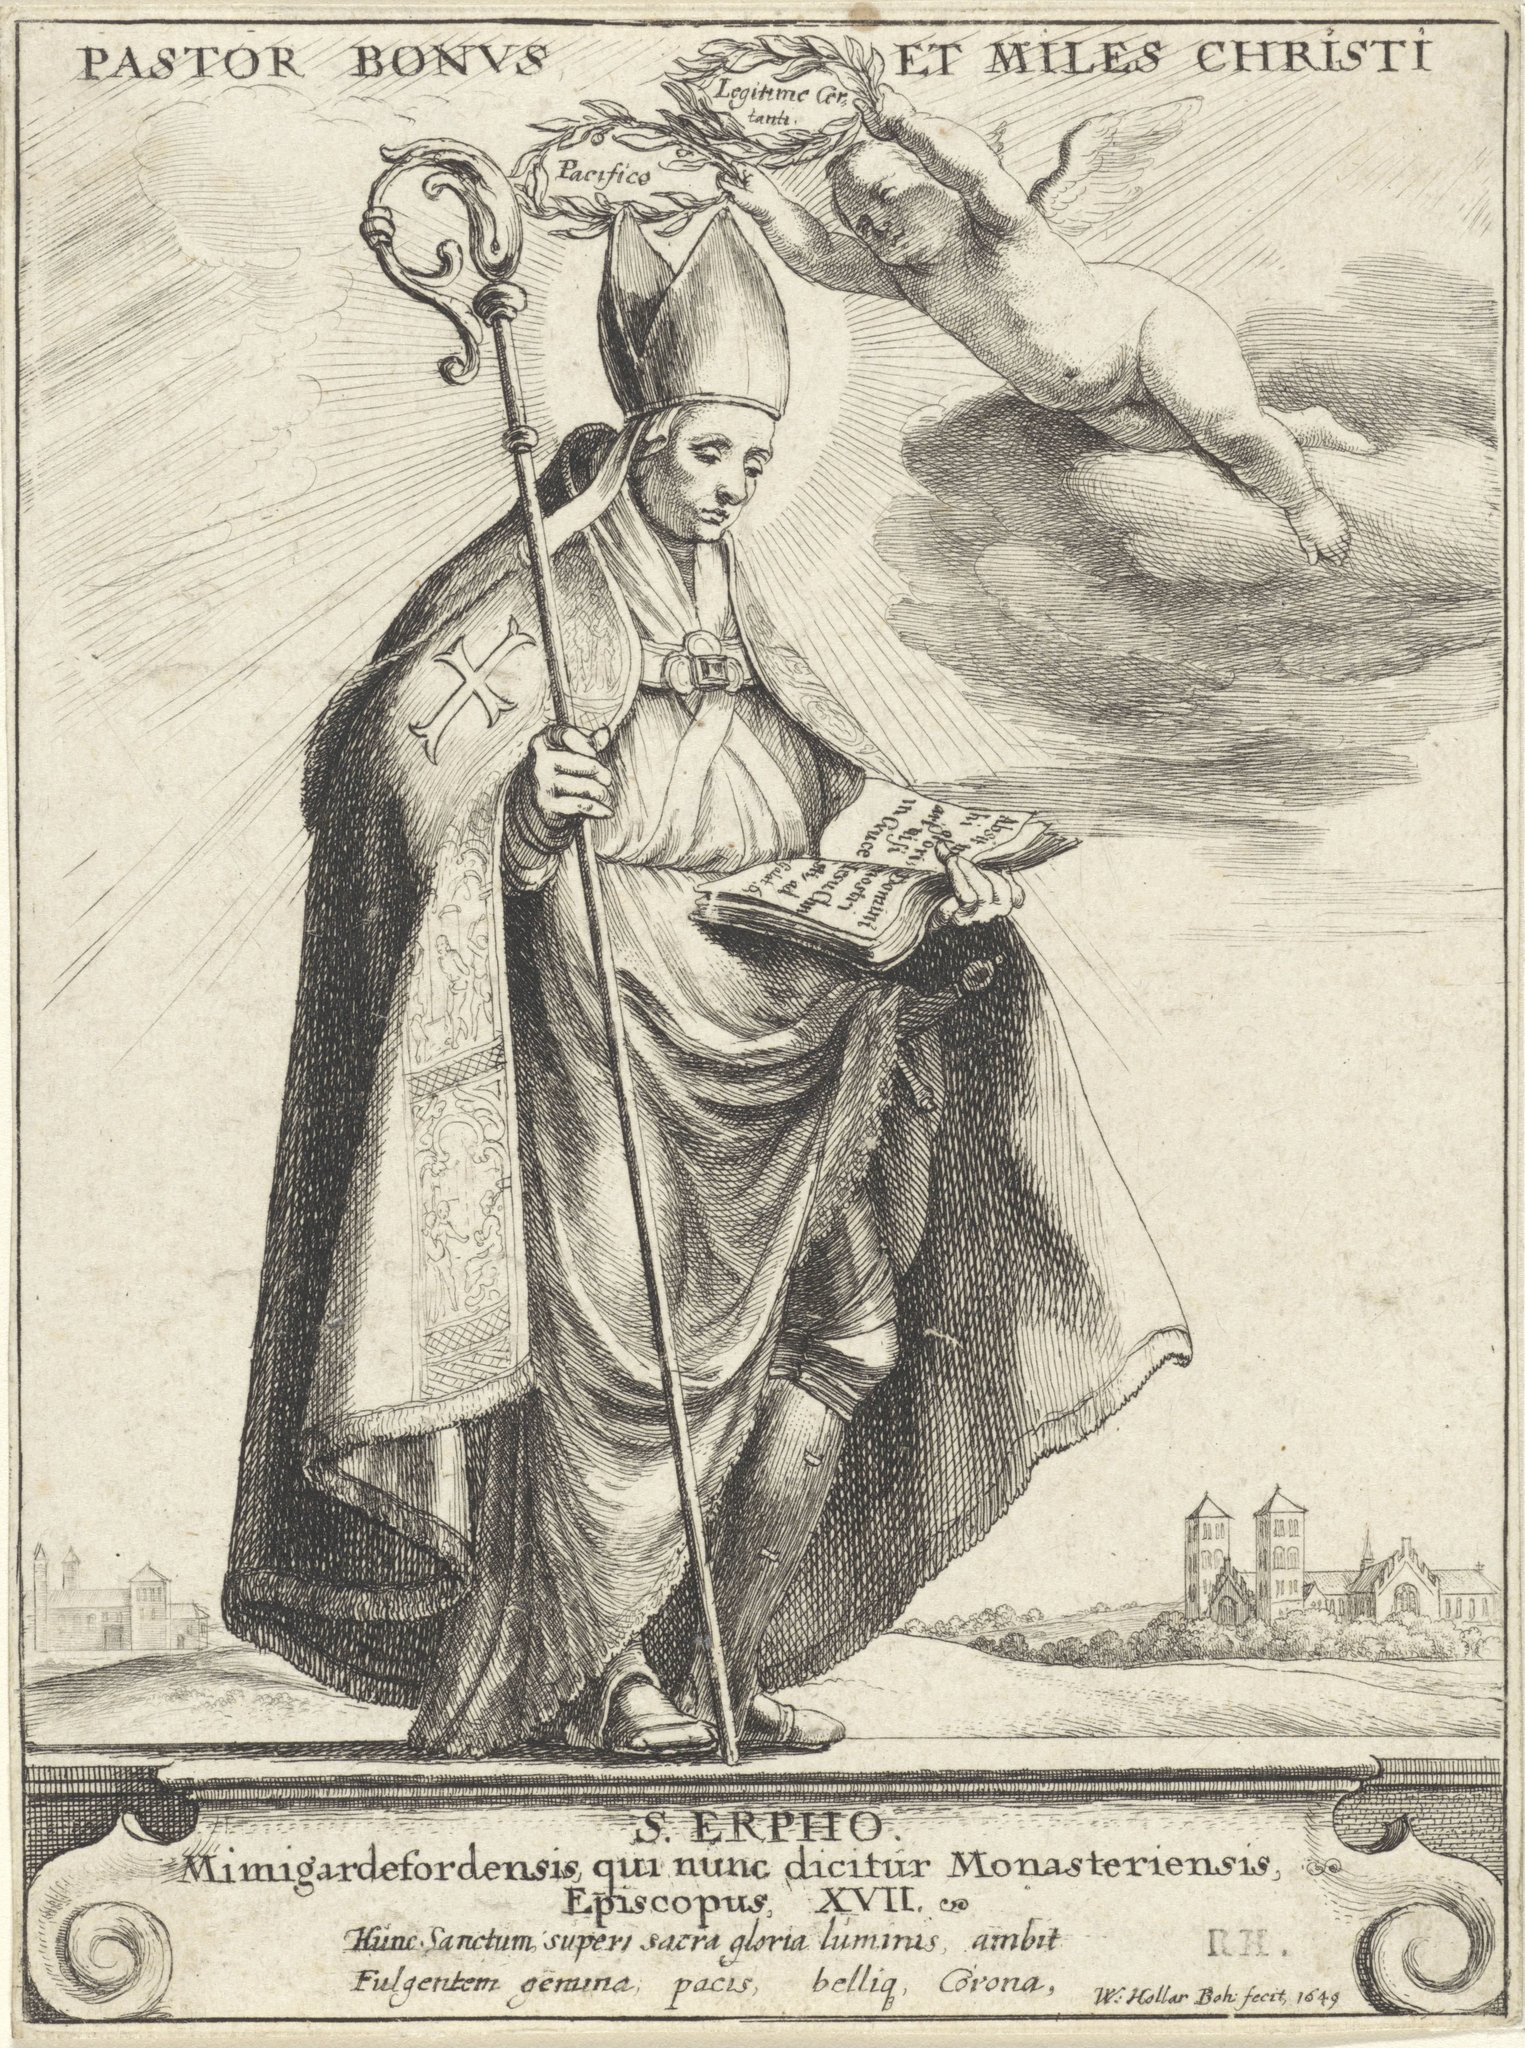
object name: print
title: H. Erpho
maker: wenceslaus hollar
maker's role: draughtsman, print maker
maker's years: 1607-1677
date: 1649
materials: paper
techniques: etching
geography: antwerp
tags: male saints (with name), crowning with laurel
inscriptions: collector's mark: Lugt 2228, collector's mark: Lugt 2214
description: De heilige Erpho door een engel gelauwerd.